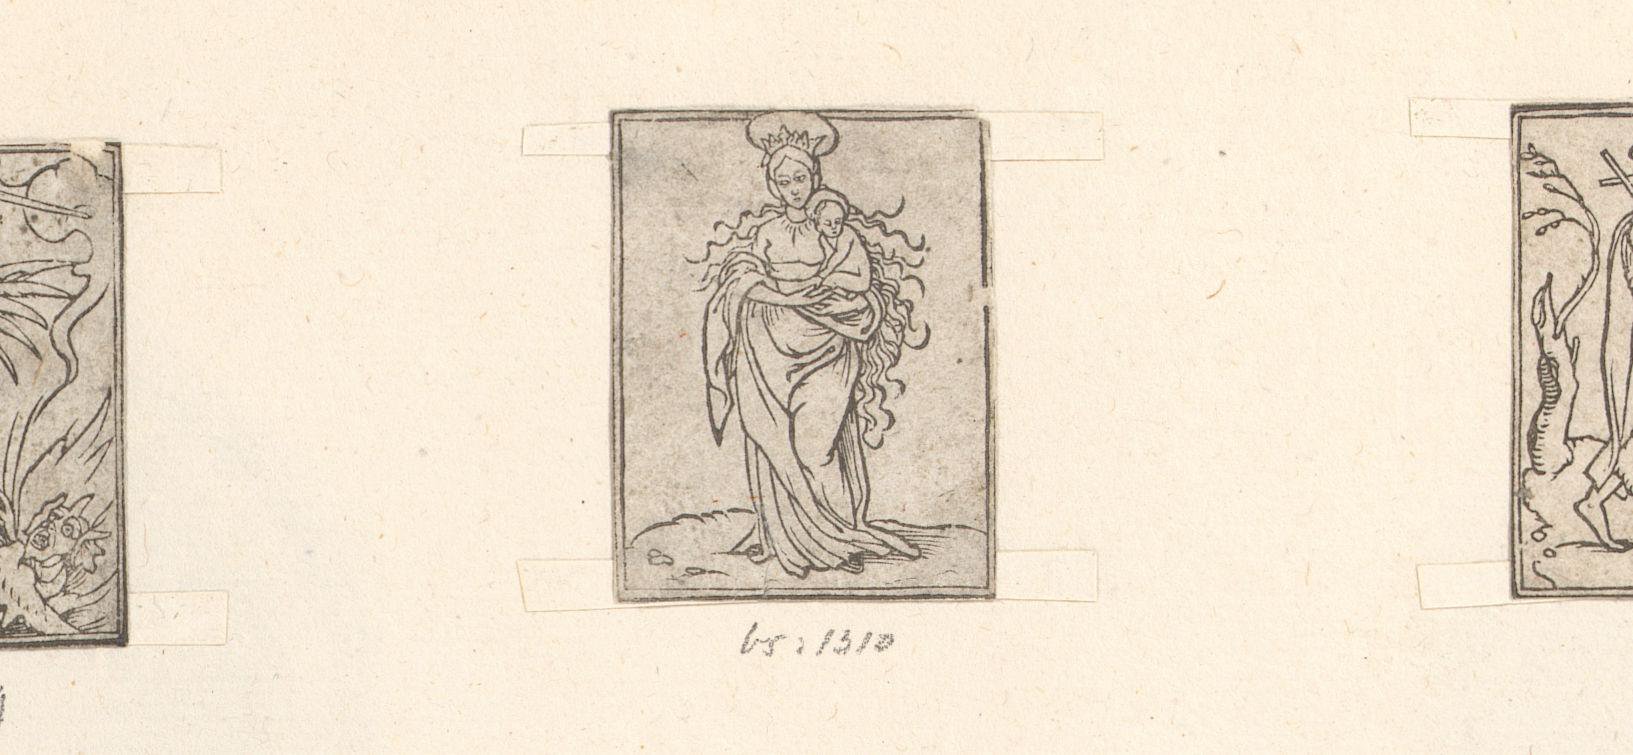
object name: print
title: Apostelen, aartsengelen en heiligen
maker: hans holbein (der jüngere)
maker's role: draughtsman, painter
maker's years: 1497-1543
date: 1507-1543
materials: paper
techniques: woodcut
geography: switzerland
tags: mary standing (or half-length), the christ-child sitting on her arm (christ-child to mary's left)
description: Maria als koningin met kroon op haar hoofd en het Christuskind op de arm. Prent maakt deel uit van een album.